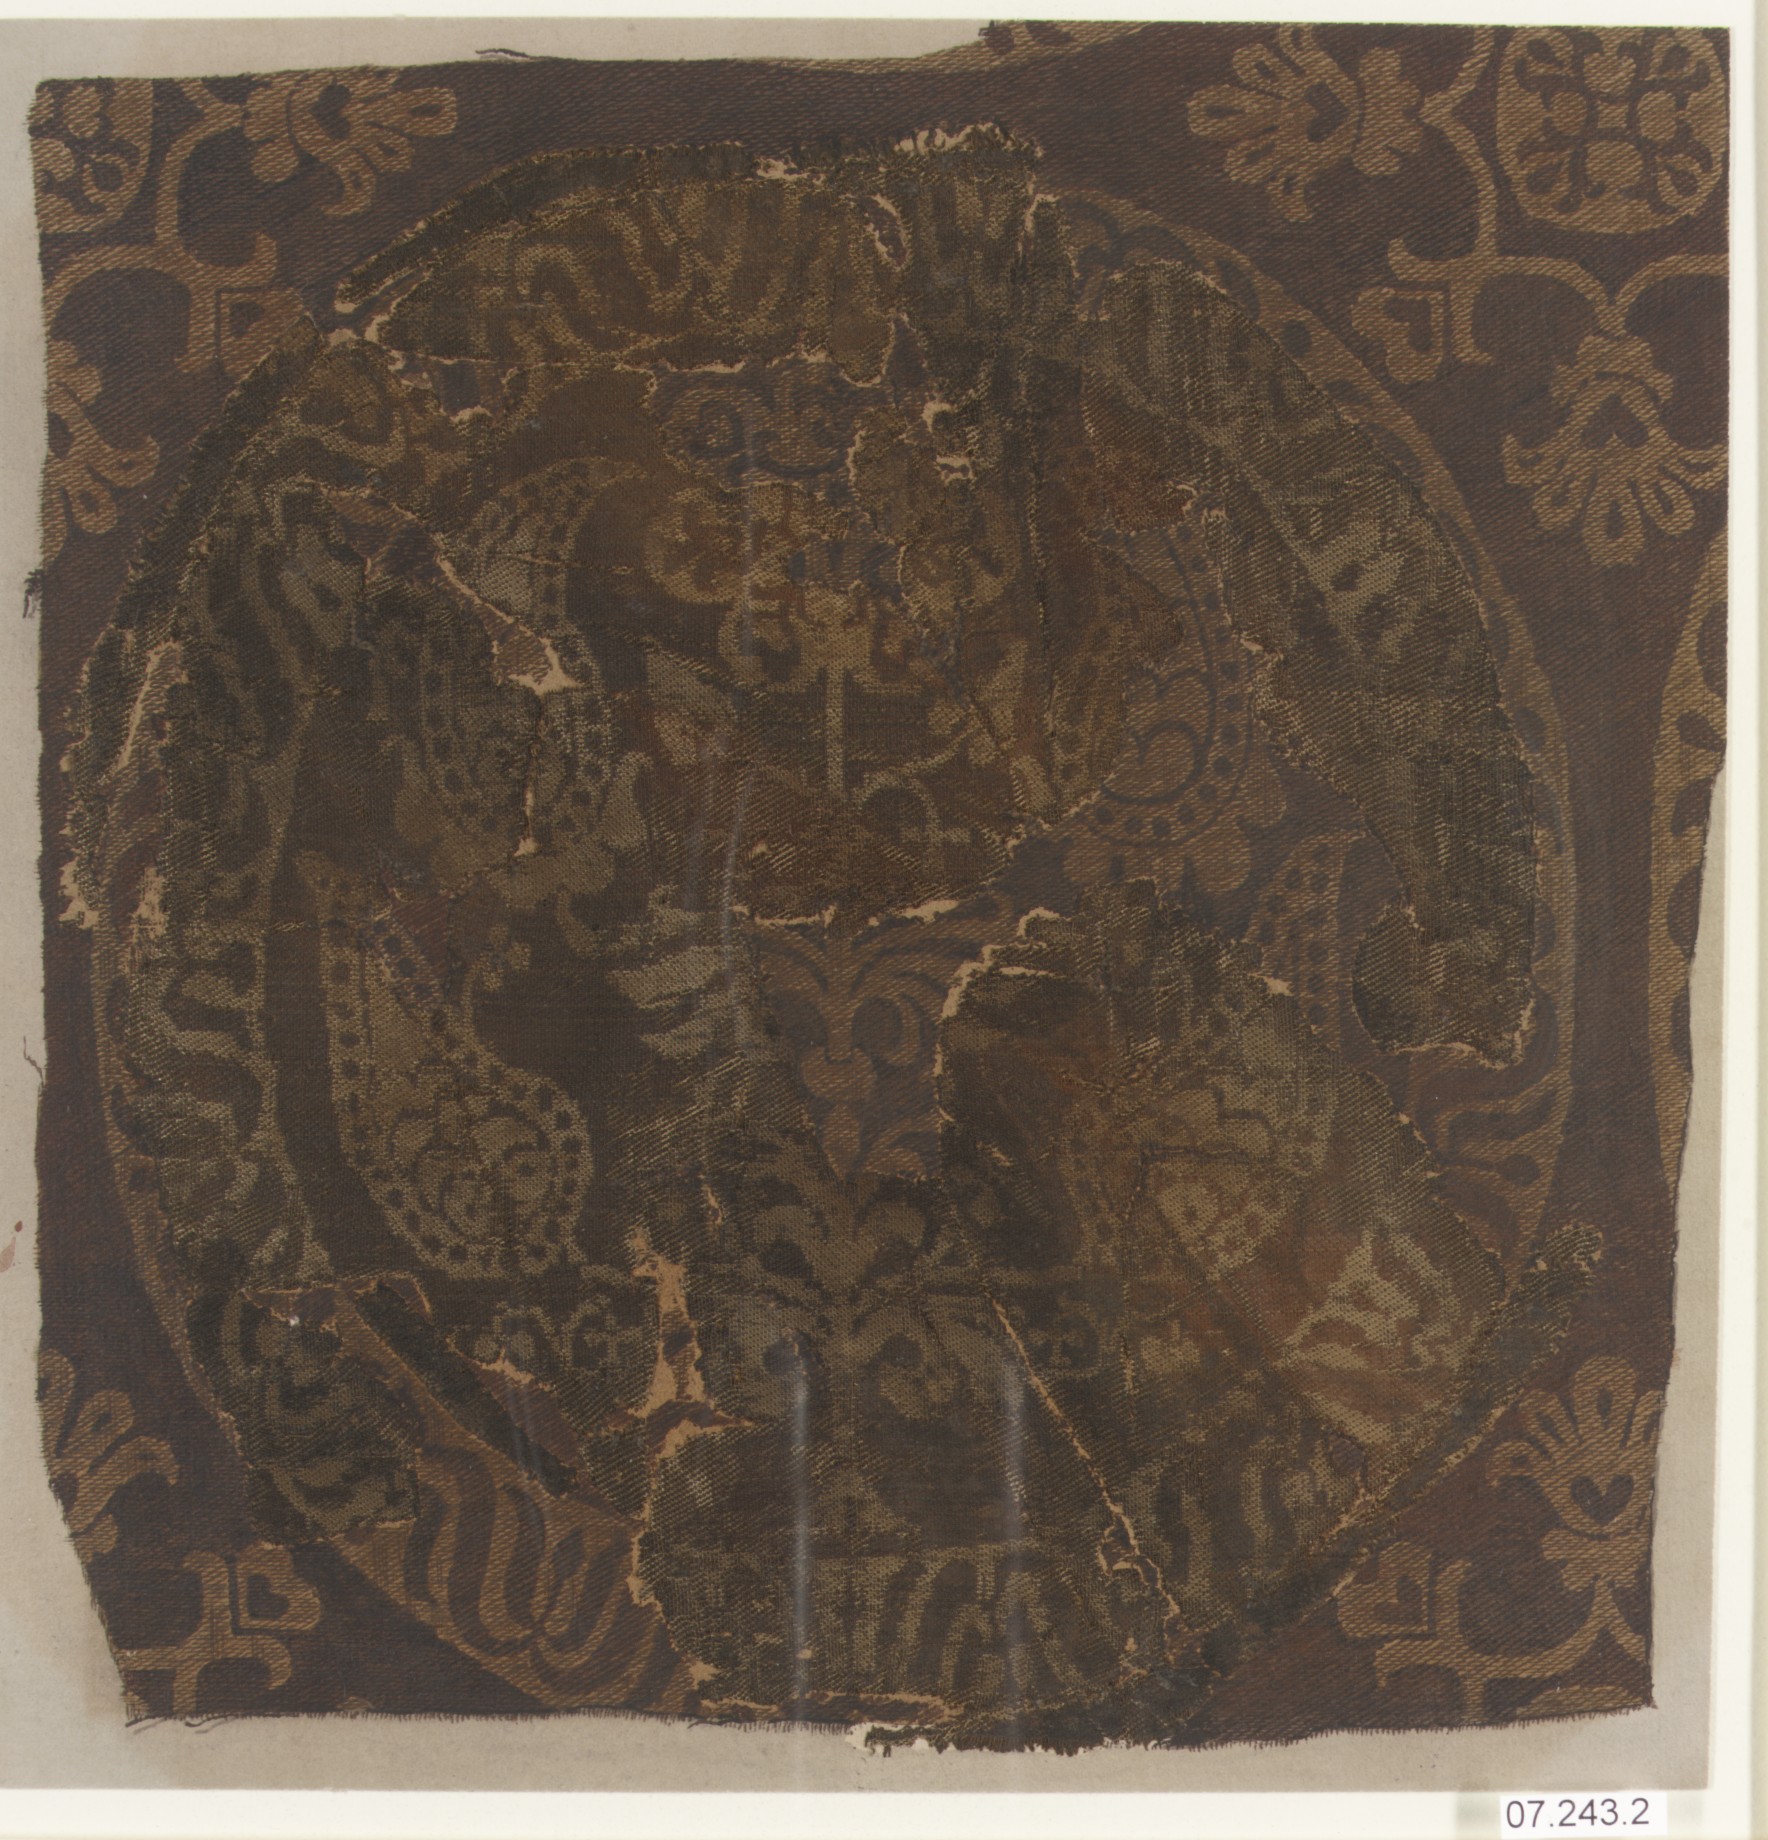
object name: textile fragment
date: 401-600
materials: silk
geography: iran